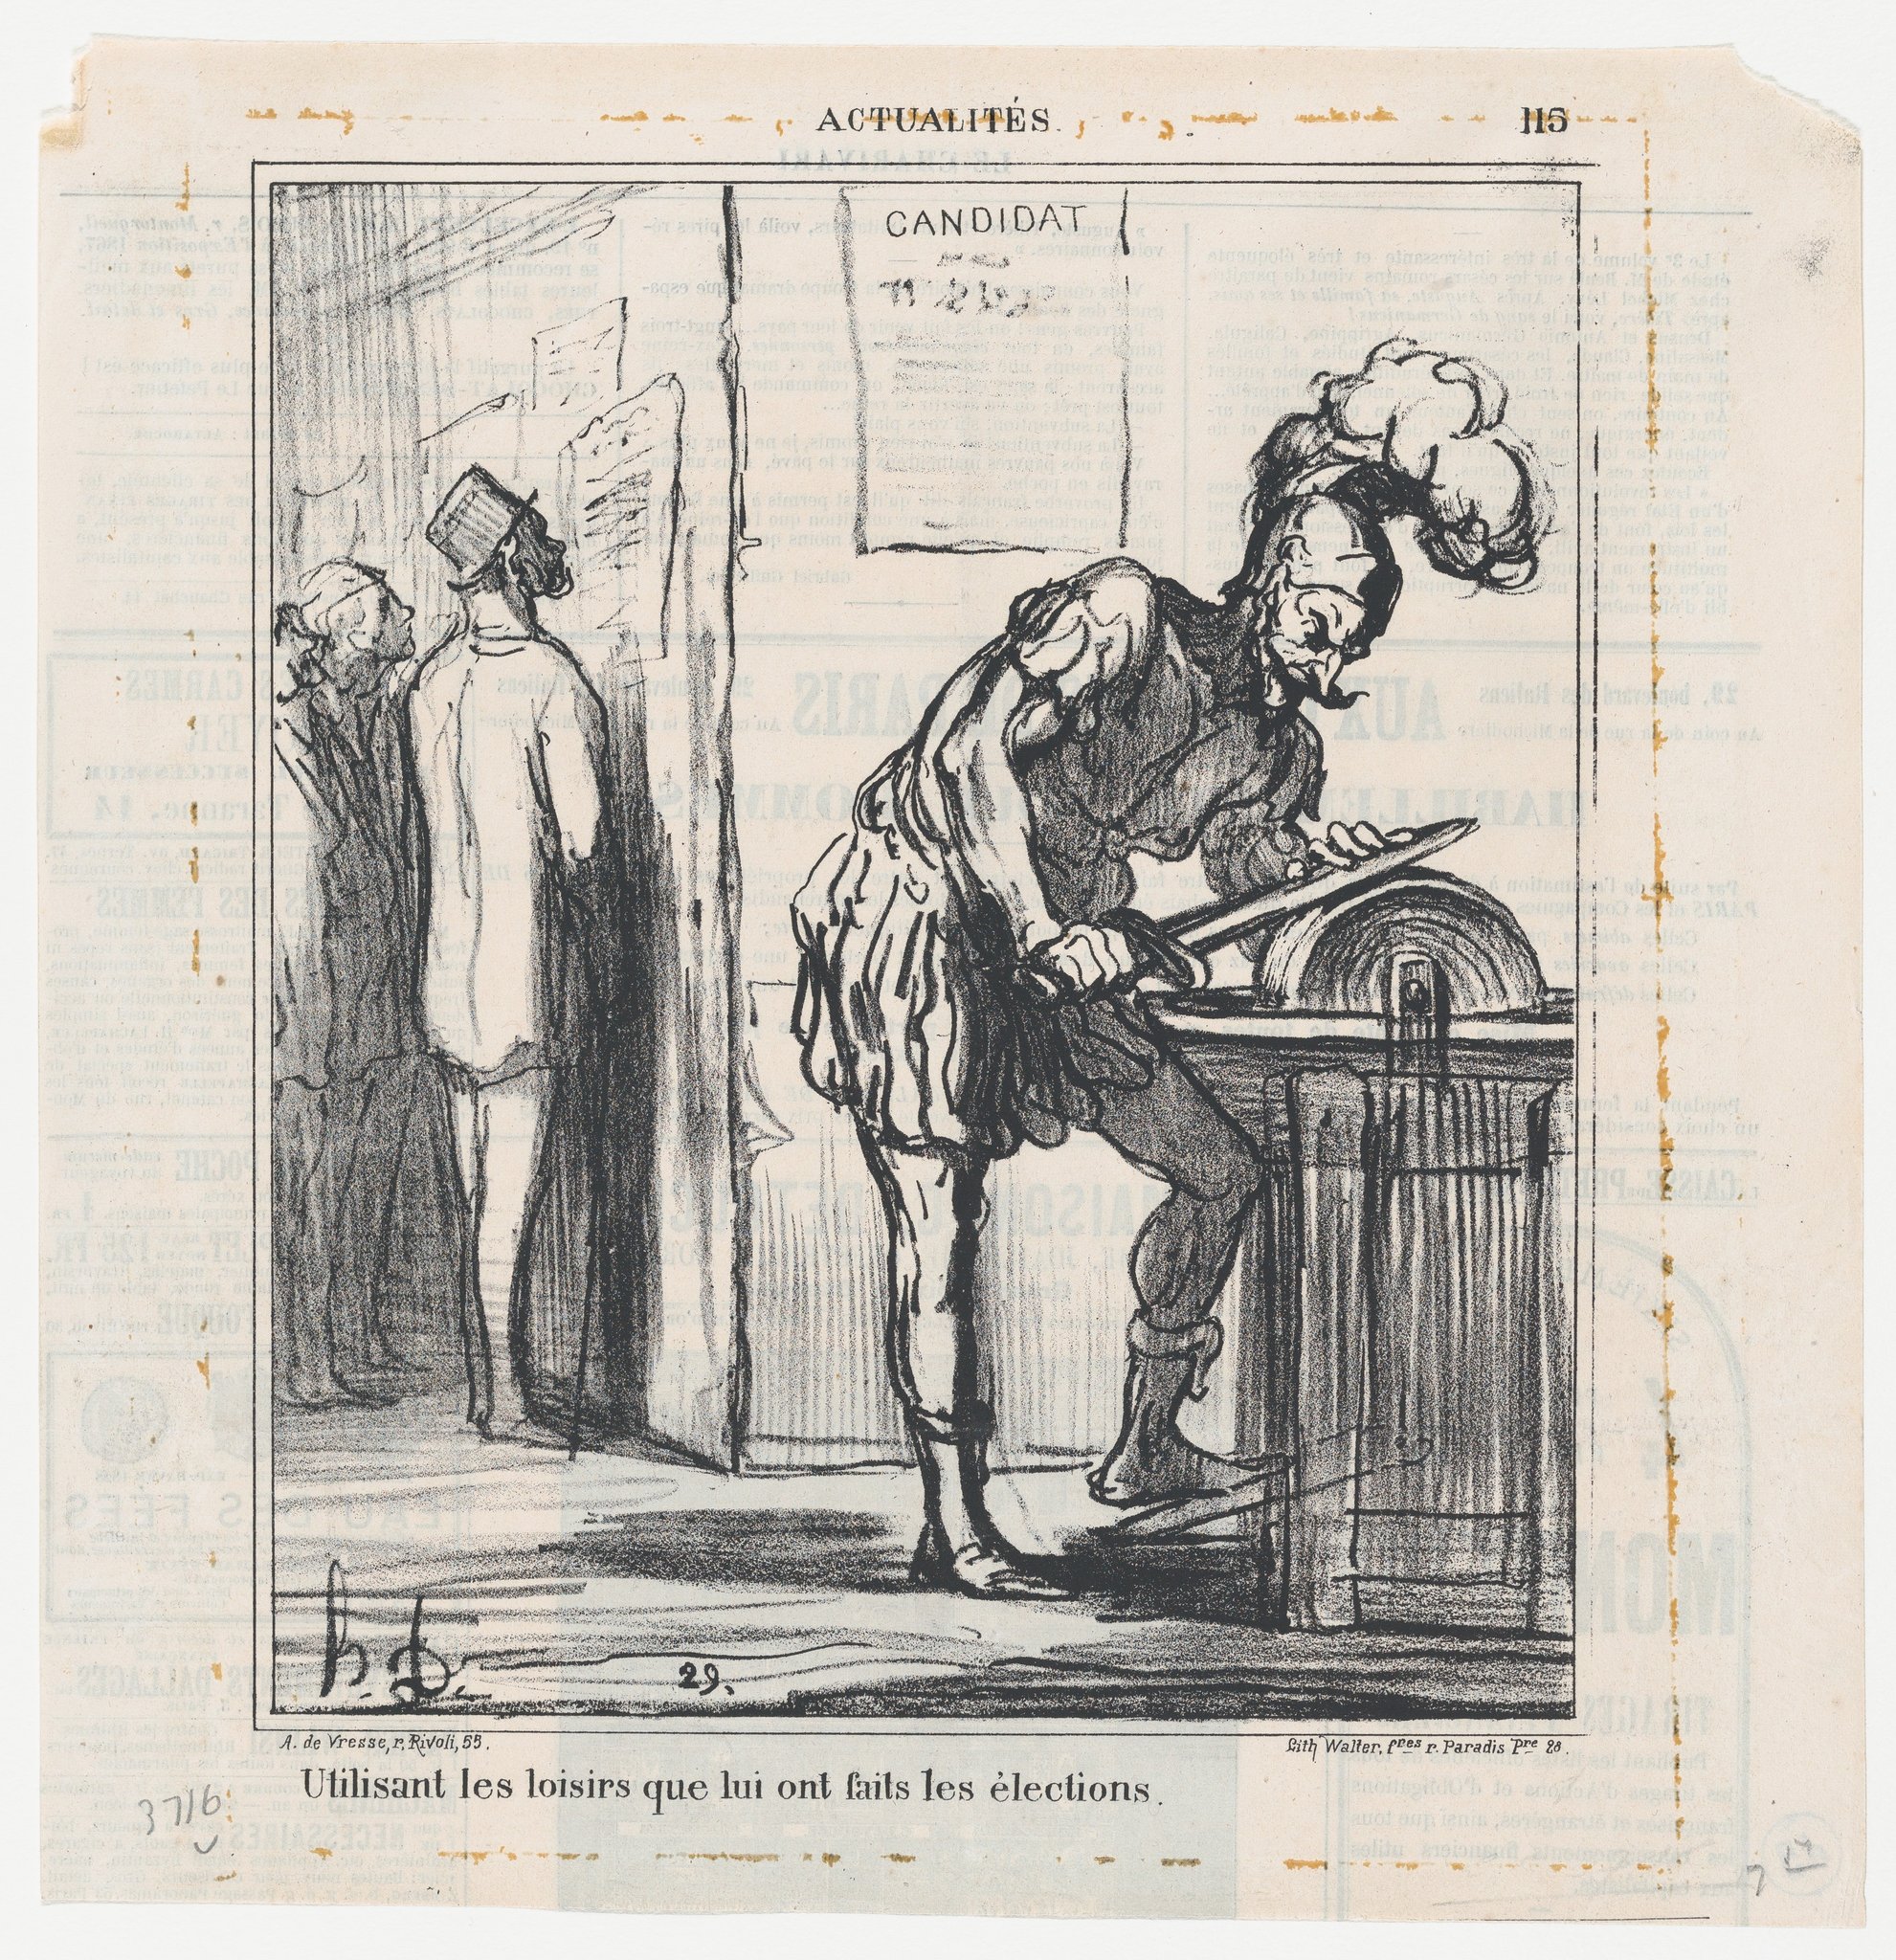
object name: print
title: Using the free time the elections have given him, from News of the day, published in "Le Charivari"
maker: honoré daumier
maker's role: artist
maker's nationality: french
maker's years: 1808-1879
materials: paper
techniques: lithograph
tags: satire,soldiers,daggers,elections,men